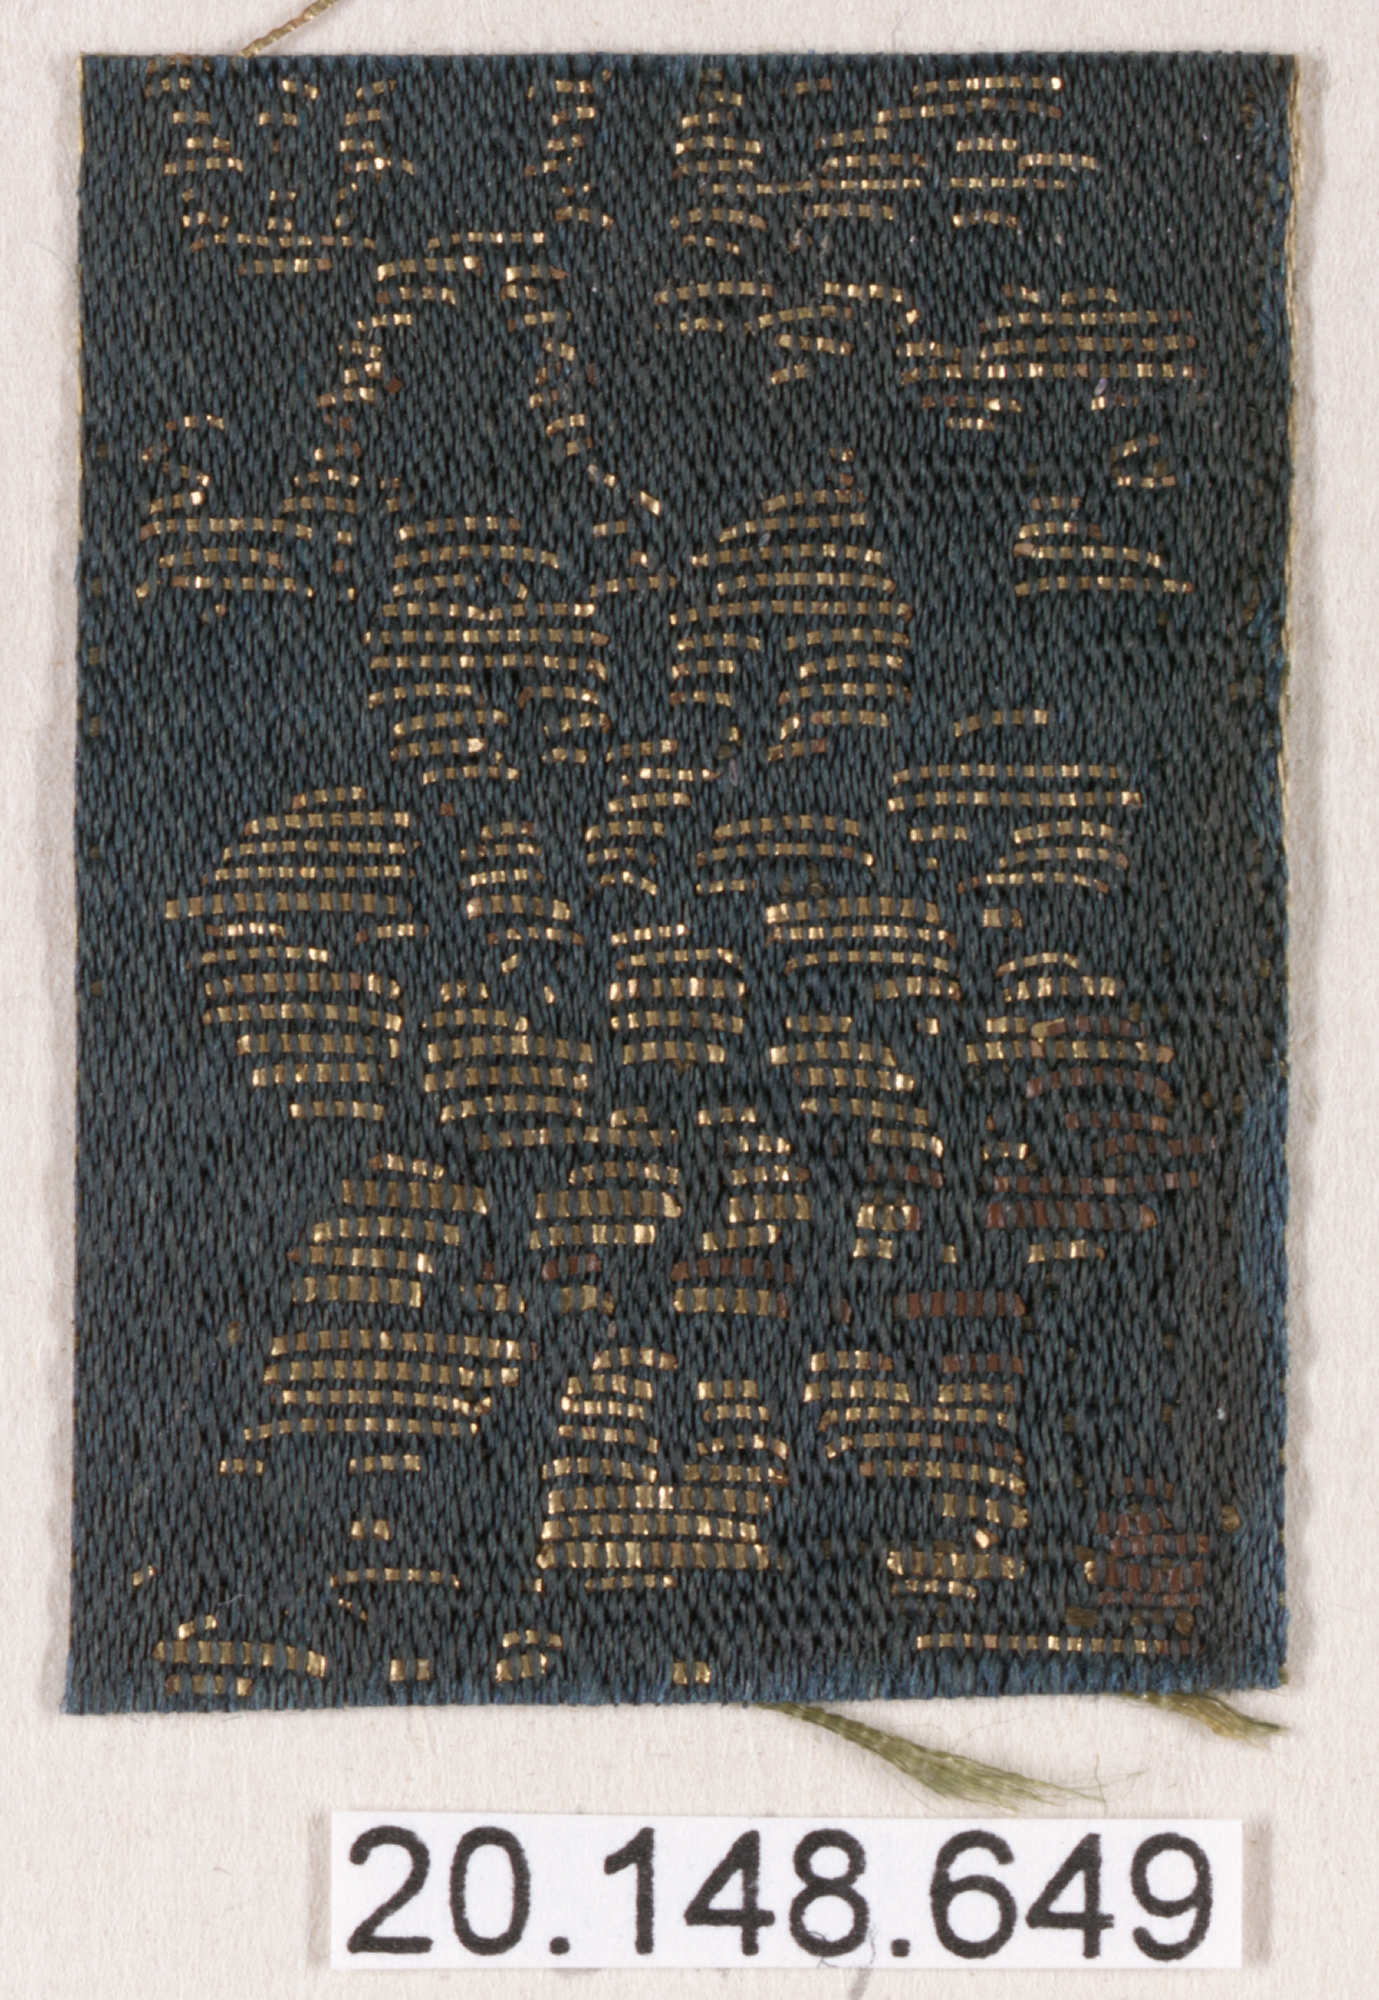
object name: piece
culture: japanese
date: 1701-1800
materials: silk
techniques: compound weave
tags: flowers,leaves